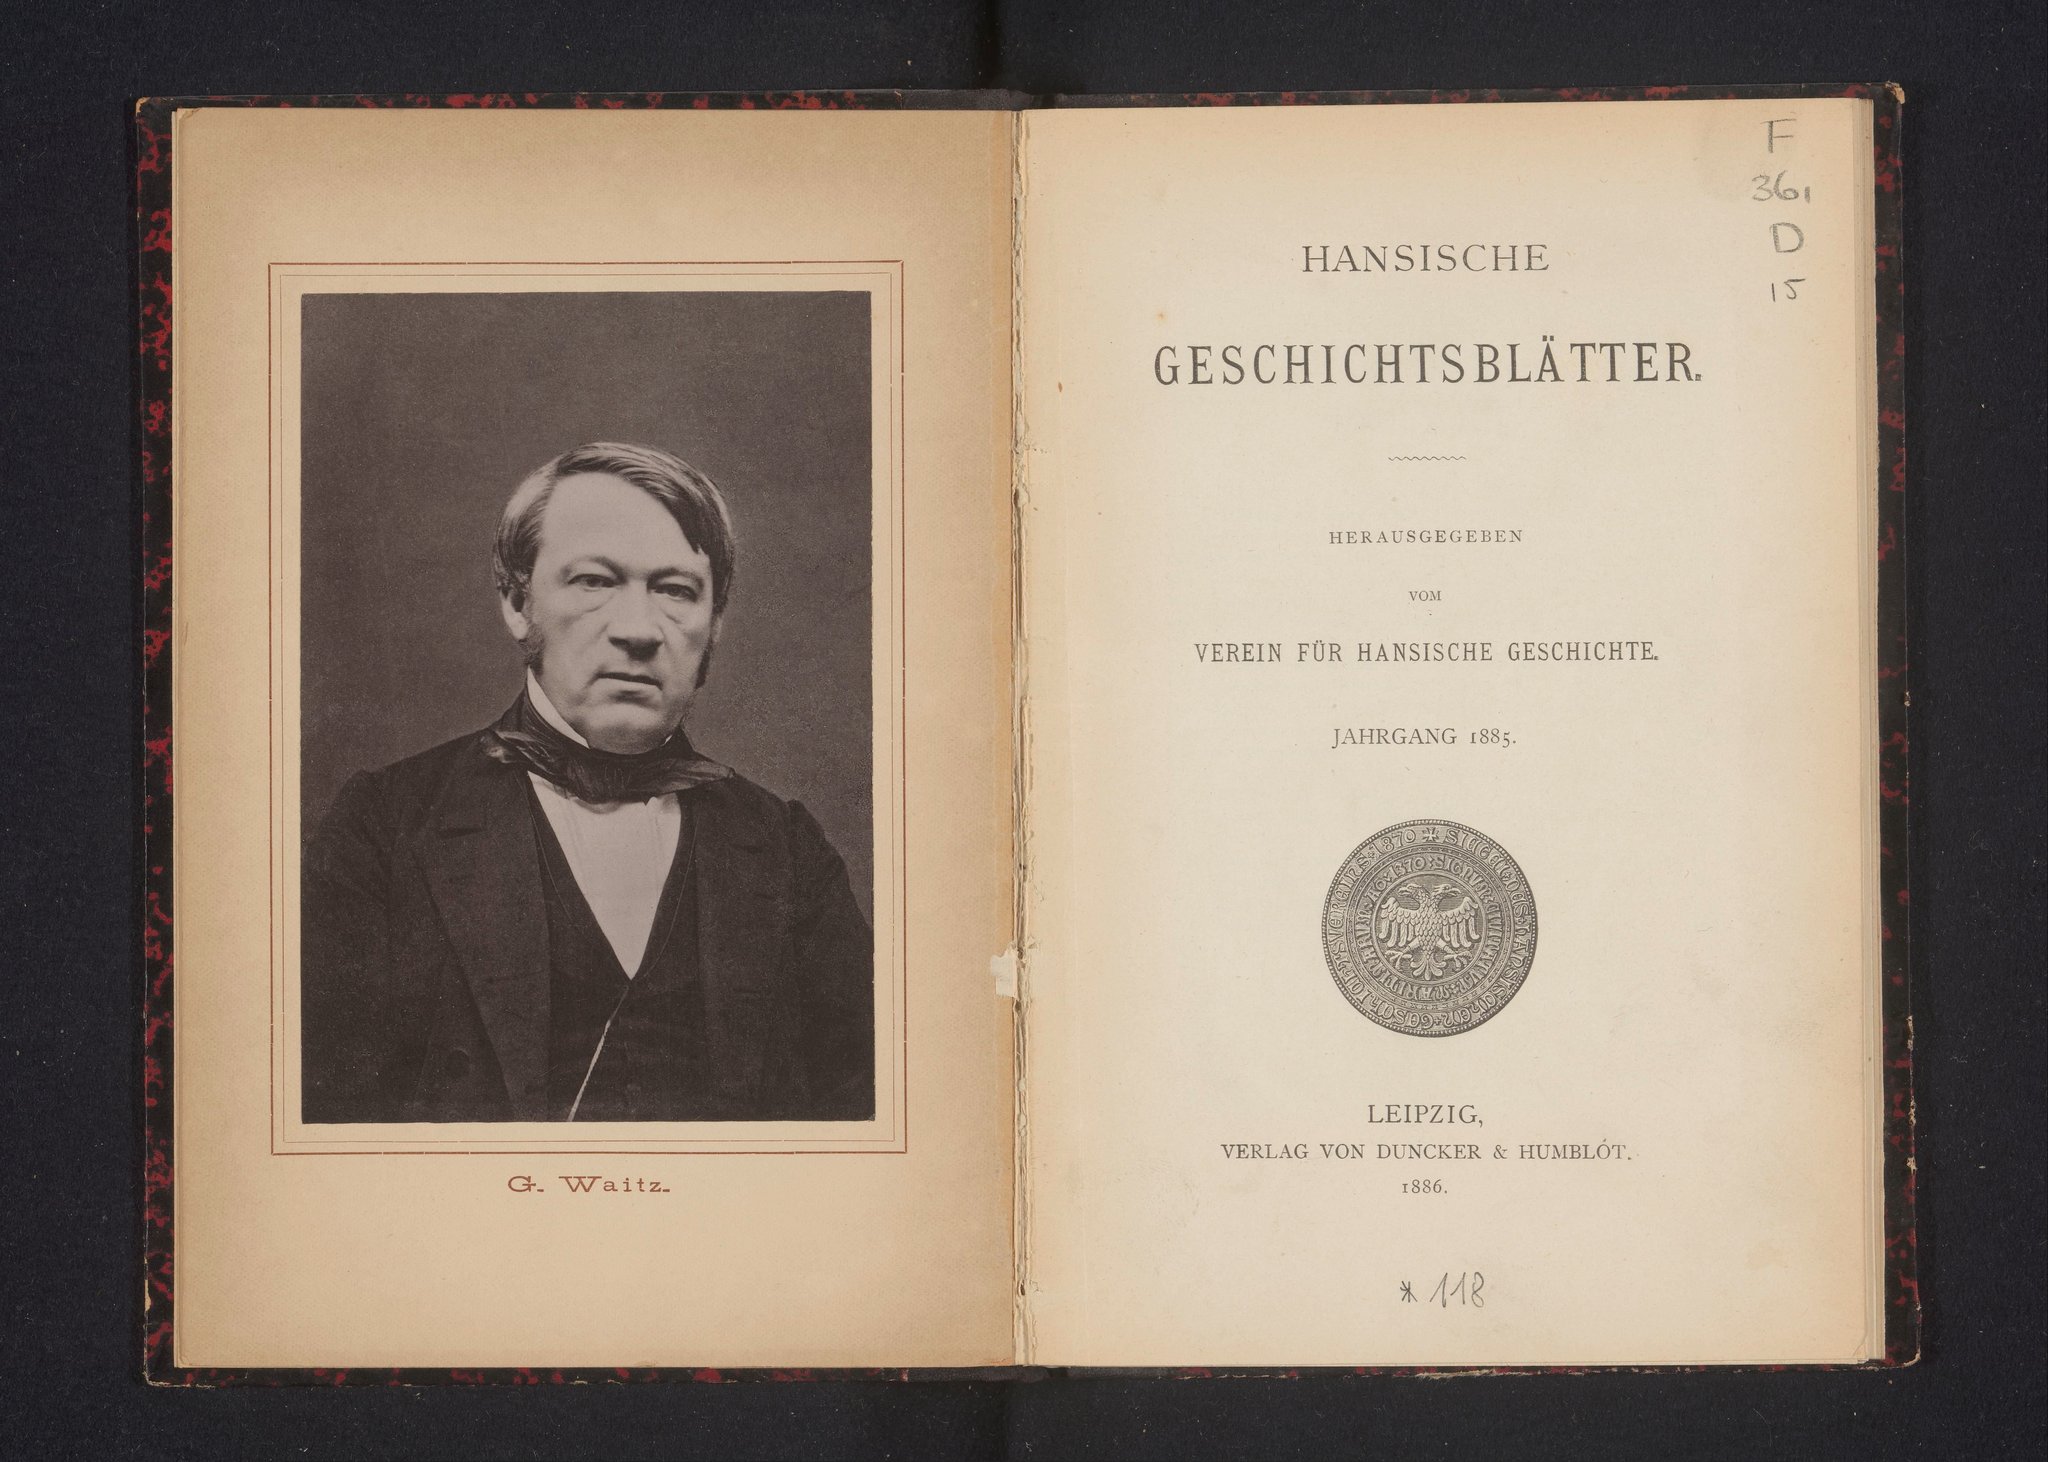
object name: book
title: Hansische Geschichtsblätter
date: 1886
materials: linen, paper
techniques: photograph, printing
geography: leipzig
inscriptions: annotation: ‘ex-N 1993’